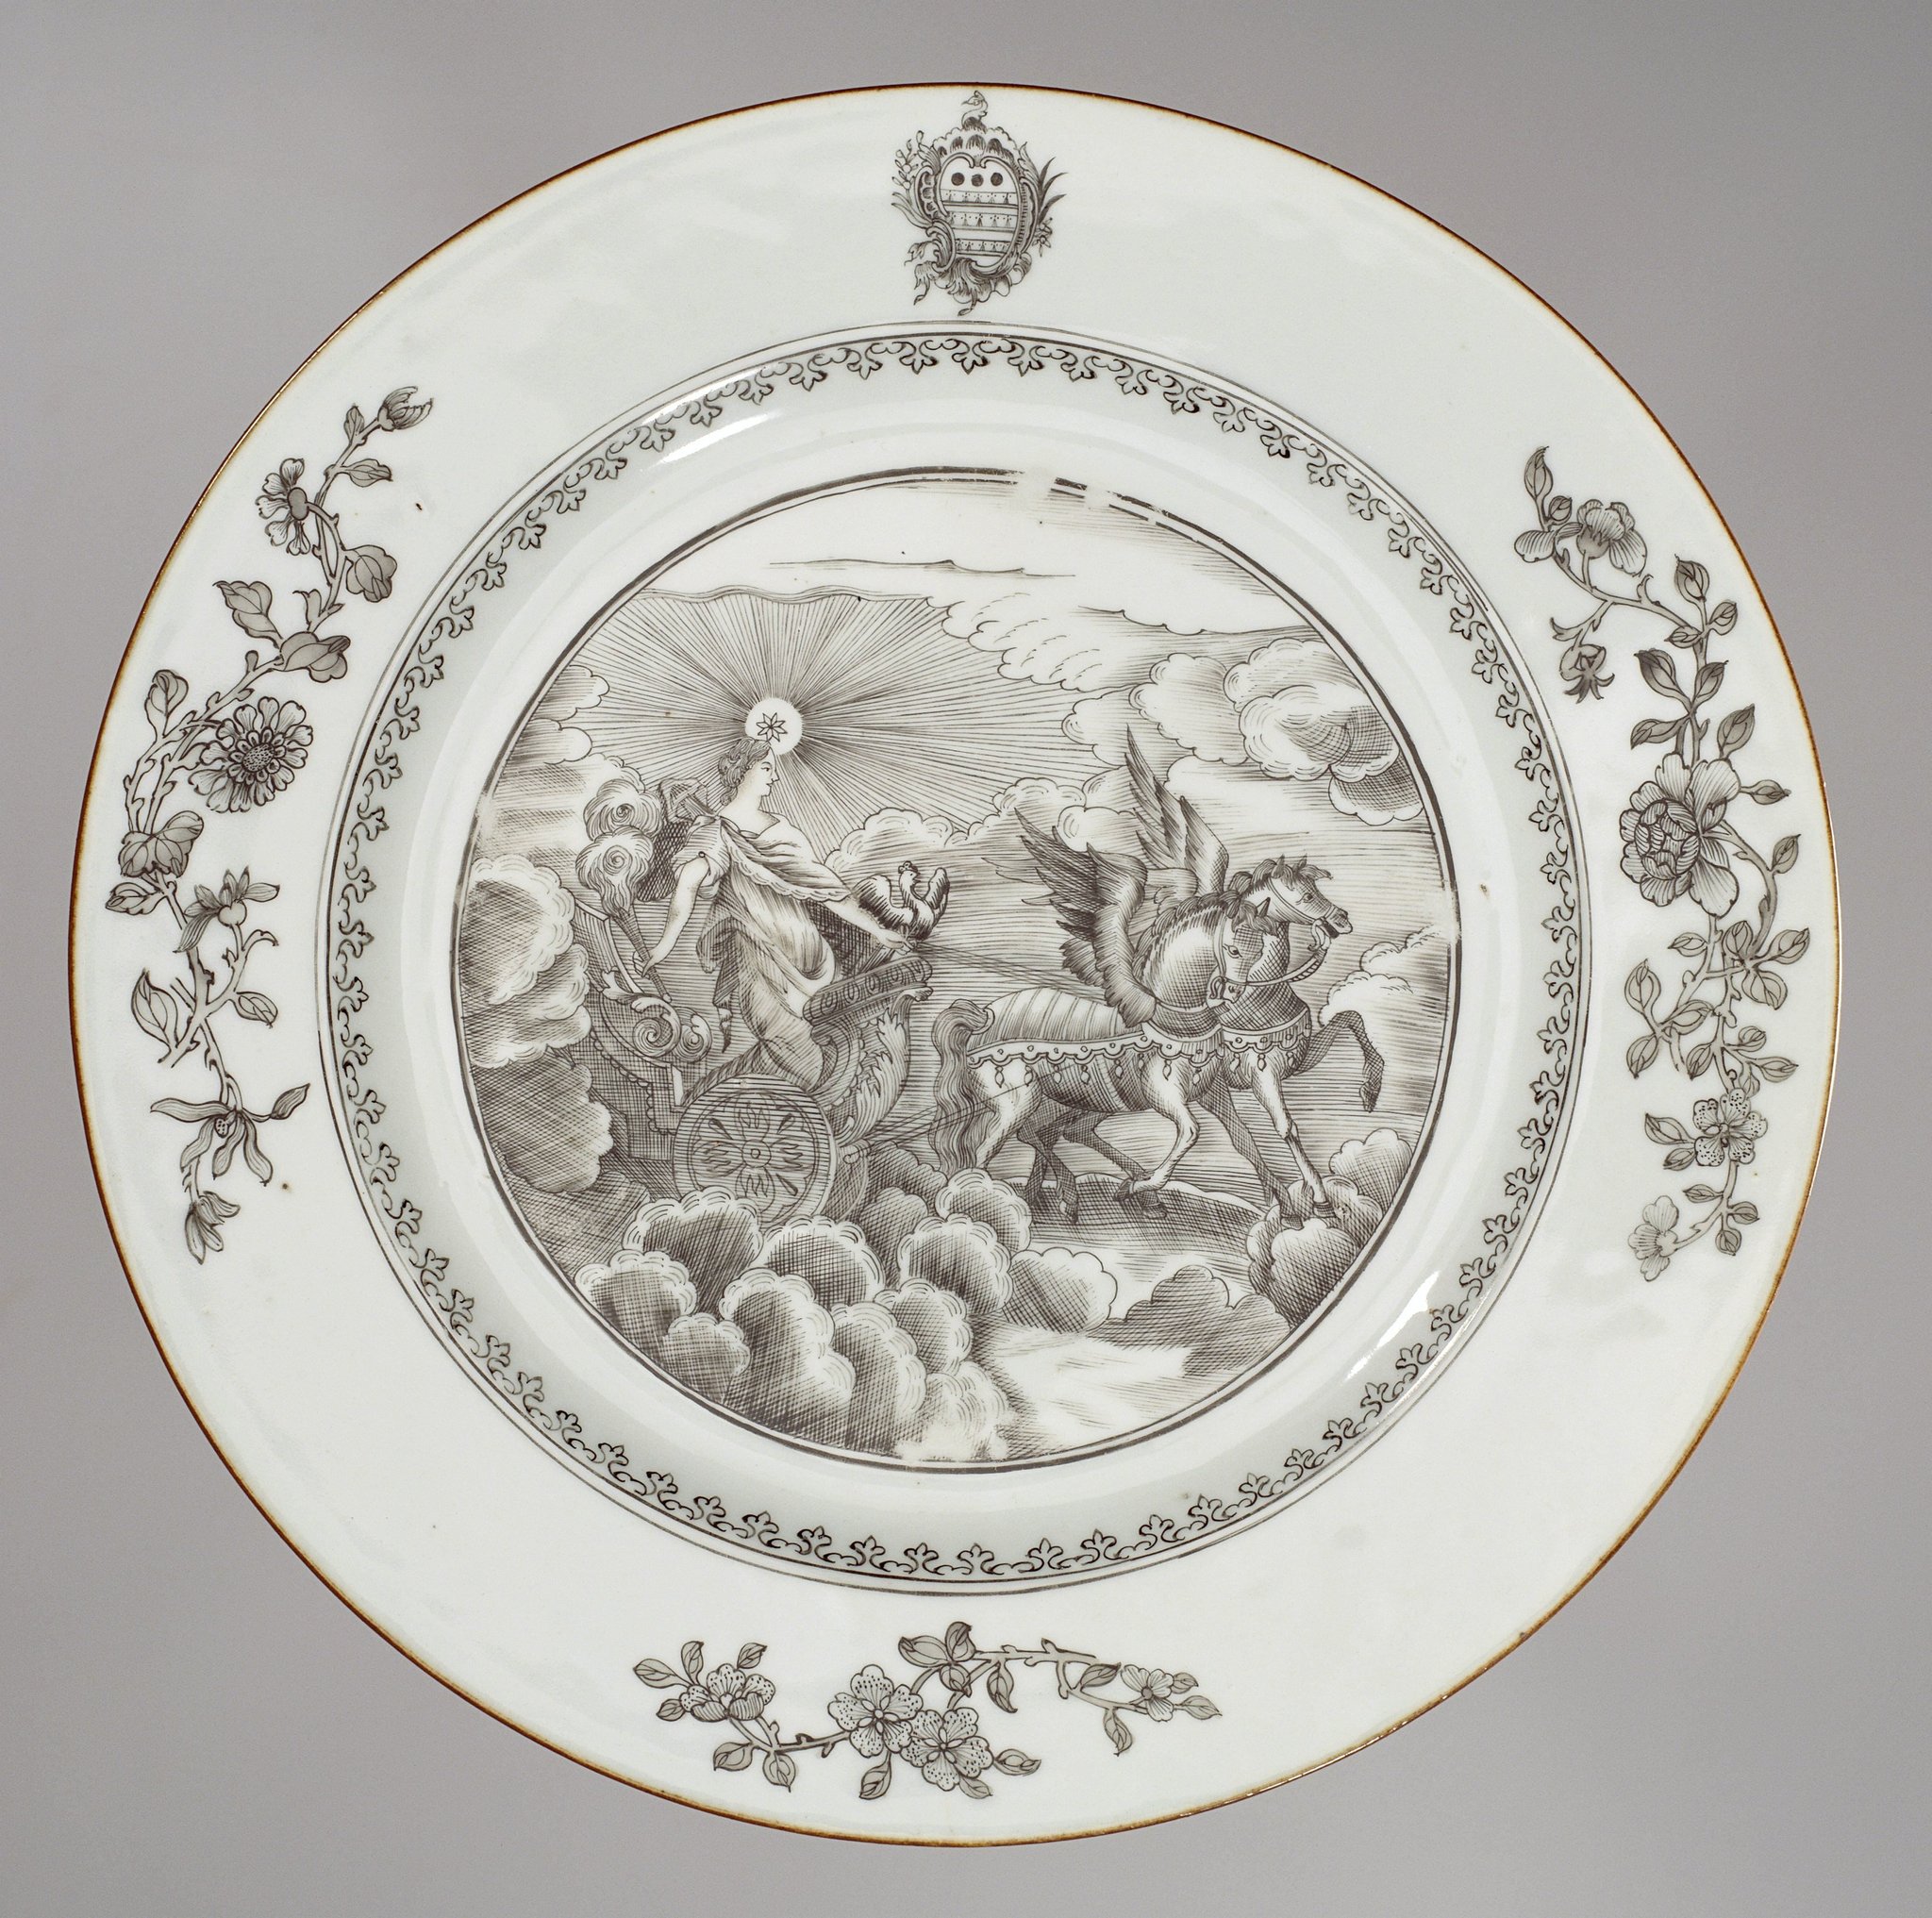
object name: plate dish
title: Plate with an image of Aurora and the coat of arms of the Humbertson family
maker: Anonymous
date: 1750-1774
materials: glaze, paint, porcelain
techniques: firing, turning, vitrification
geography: china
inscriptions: label: ‘9/ Aurora/ N.[?] Wattkins [...]’, label: ‘F. Bodenham/ Elmhurst, Hereford/ 71’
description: Bord op een voetring, gedecoreerd in encre de Chine en goud. Centraal een mythologische voorstelling, rondom een fleur de lys-rand. Op de rand drie plukken bloemen en bovenaan een wapen van de familie Humbertson. Deze mooi uitgevoerde voorstelling is die van de ‘stralende’ Apollo, god van het goede en het schone, hij handhaaft recht en orde, desnoods met straffe hand. Hij is tevens god van de wijsheid, het licht, de muziek en poëzie, én een orakelgod, die de wil van de goden openbaart. Op deze voorstelling is Apollo als zonnengod afgebeeld. Hij staat in een wagen, getrokken door twee gevleugelde paarden; rondom wolken. Op de achtergrond het stralende licht.